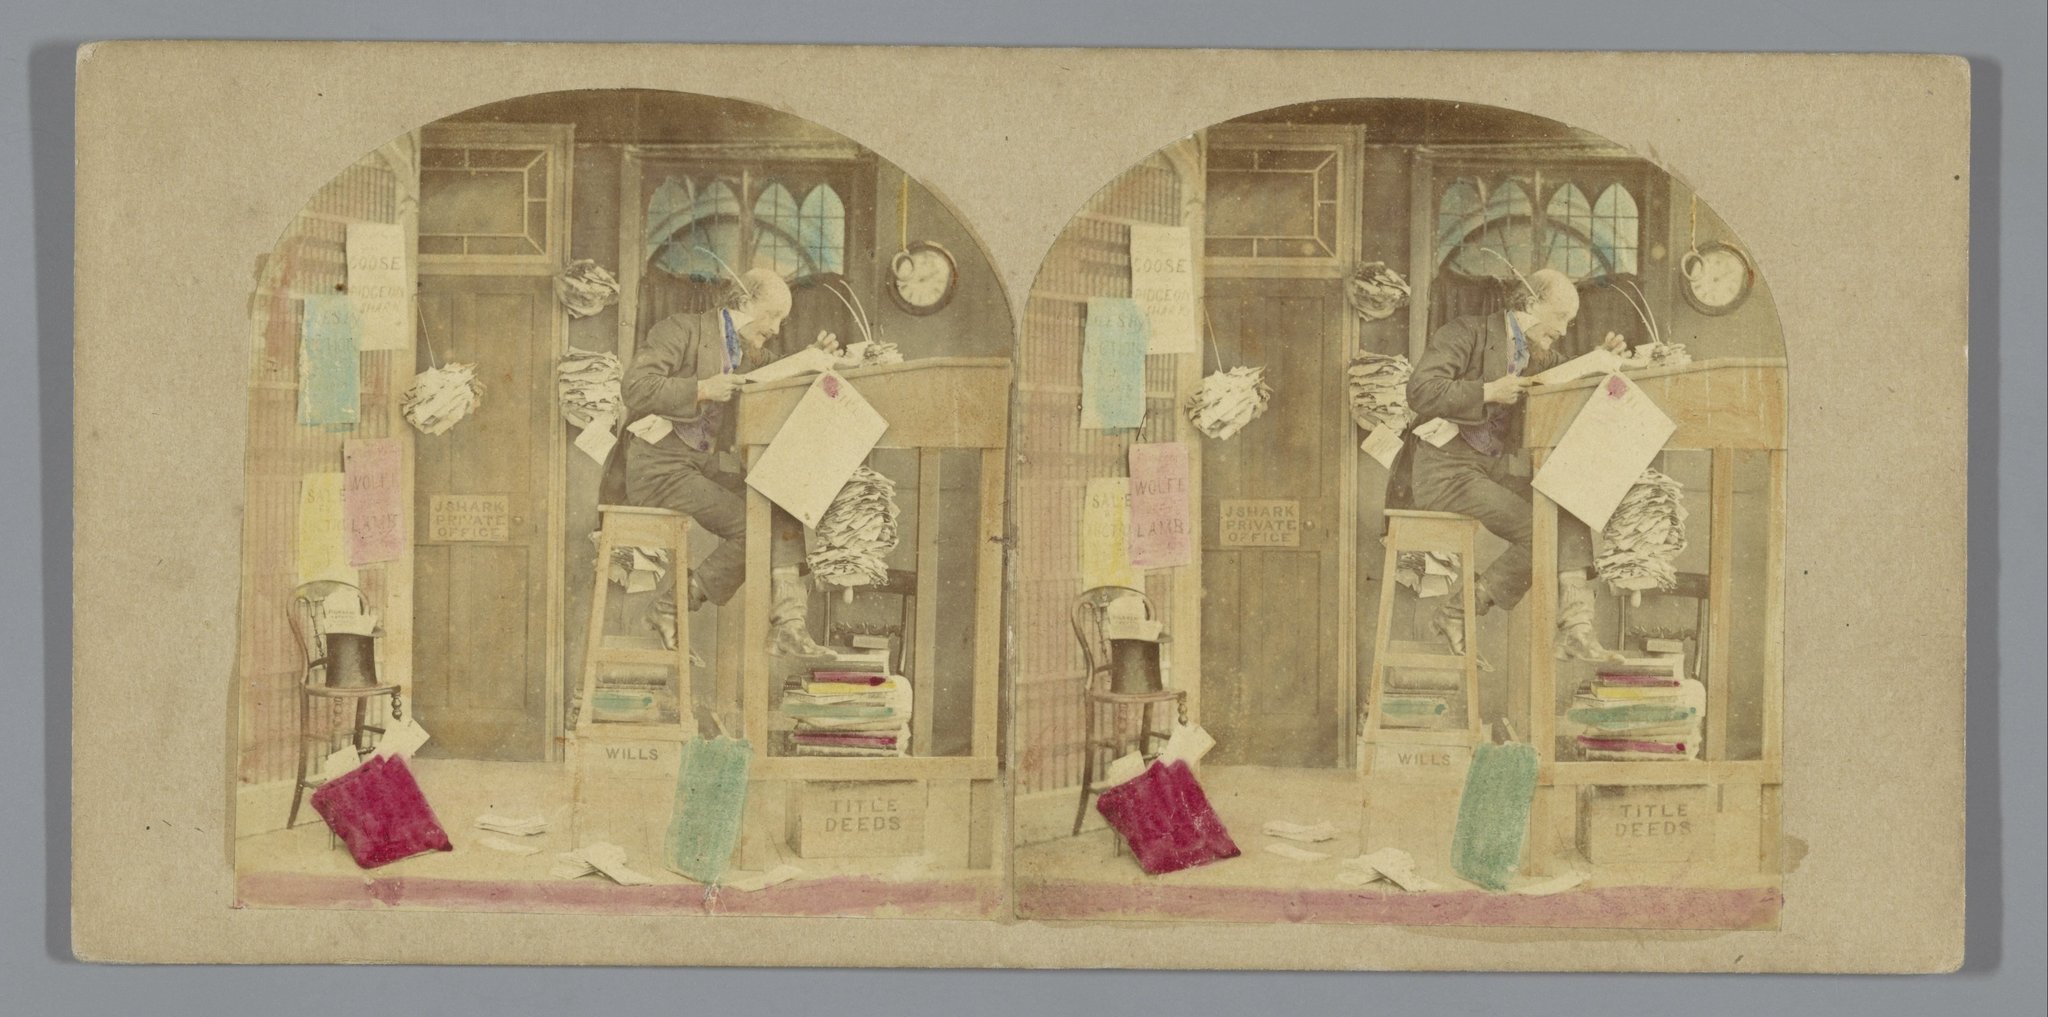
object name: stereograph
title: John Quill, klerk van Robert Shark, zittend op een hoge kruk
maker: Anonymous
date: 1852-1863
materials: cardboard, paper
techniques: albumen print, hand coloring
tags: sales clerk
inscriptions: inscription: ‘John Quill./ John Quill was clerk to Robert Shark, a legal man was he, (...)’